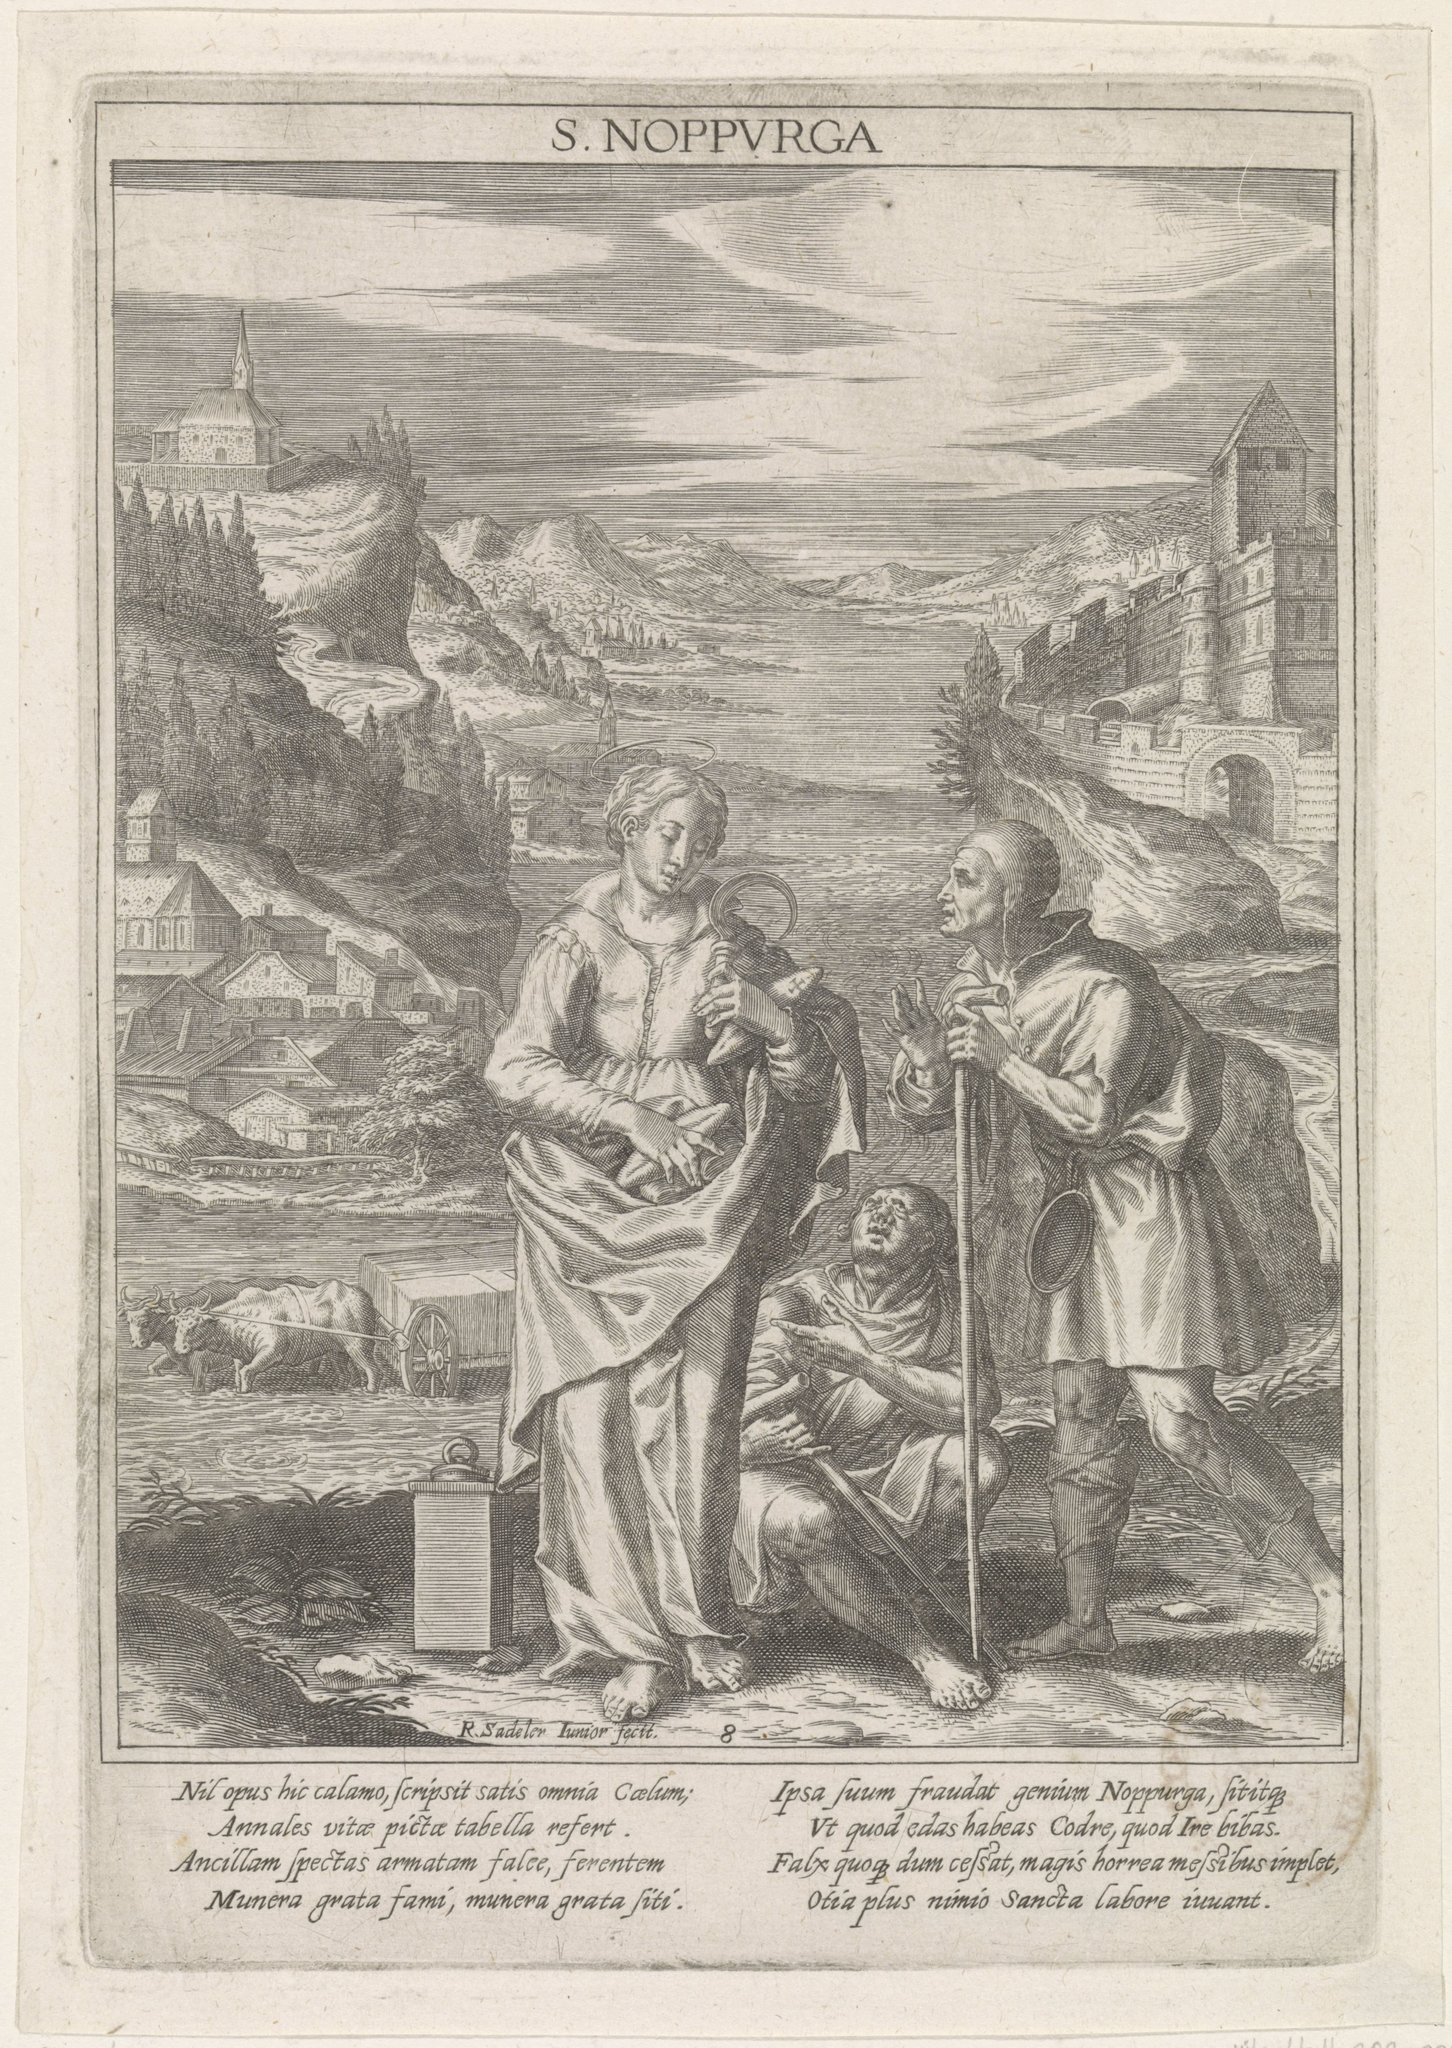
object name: print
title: Heilige Notburga van Eben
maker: raphaël sadeler (ii)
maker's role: print maker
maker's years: 1584-1632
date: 1627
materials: paper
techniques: engraving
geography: munich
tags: giving alms or other charity, e.g.: handing out food, female saints (with name), river, rocky coast, beggar, agricultural implements: sickle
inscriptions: collector's mark: Lugt 240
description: H. Notburga van Eben op de voorgrond, een sikkel en twee broden in haar handen. Naast haar twee bedelaars aan wie ze het brood zal uitdelen. Op de achtergrond het kasteel Rattenberg. De prent heeft een Latijns onderschrift.